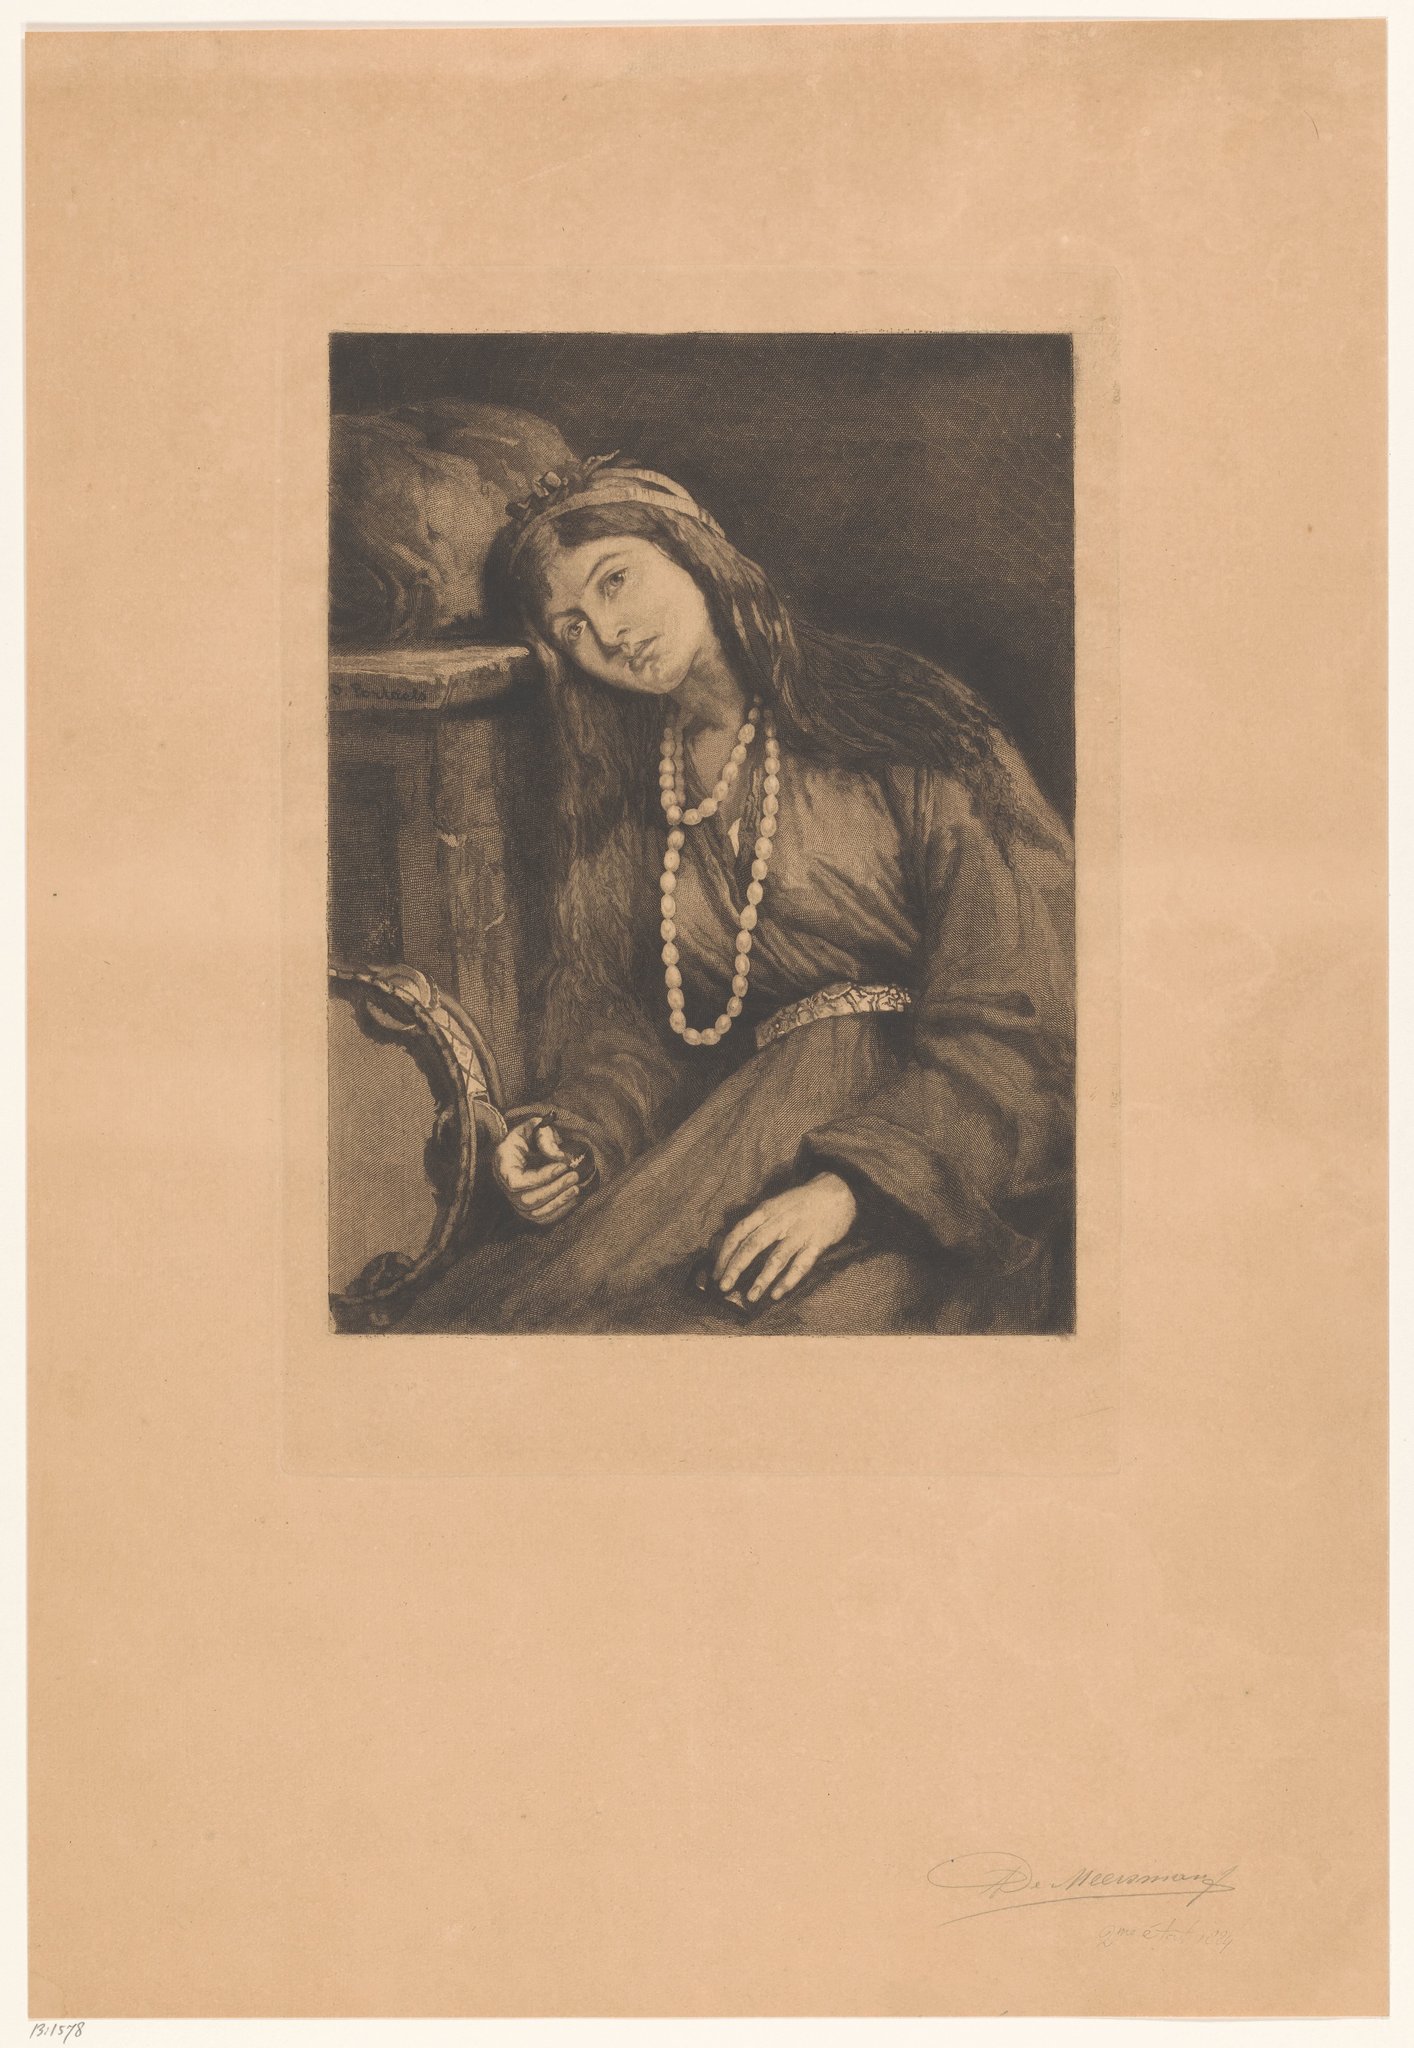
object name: print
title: Rustende muzikante met castagnetten en tamboerijn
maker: françois de meersman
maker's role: print maker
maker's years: 1830-1905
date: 1884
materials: paper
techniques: etching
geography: belgium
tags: adolescent, young woman, maiden, tambourine, clappers, castanets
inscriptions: annotation: ‘2me état’, collector's mark: Lugt 2228